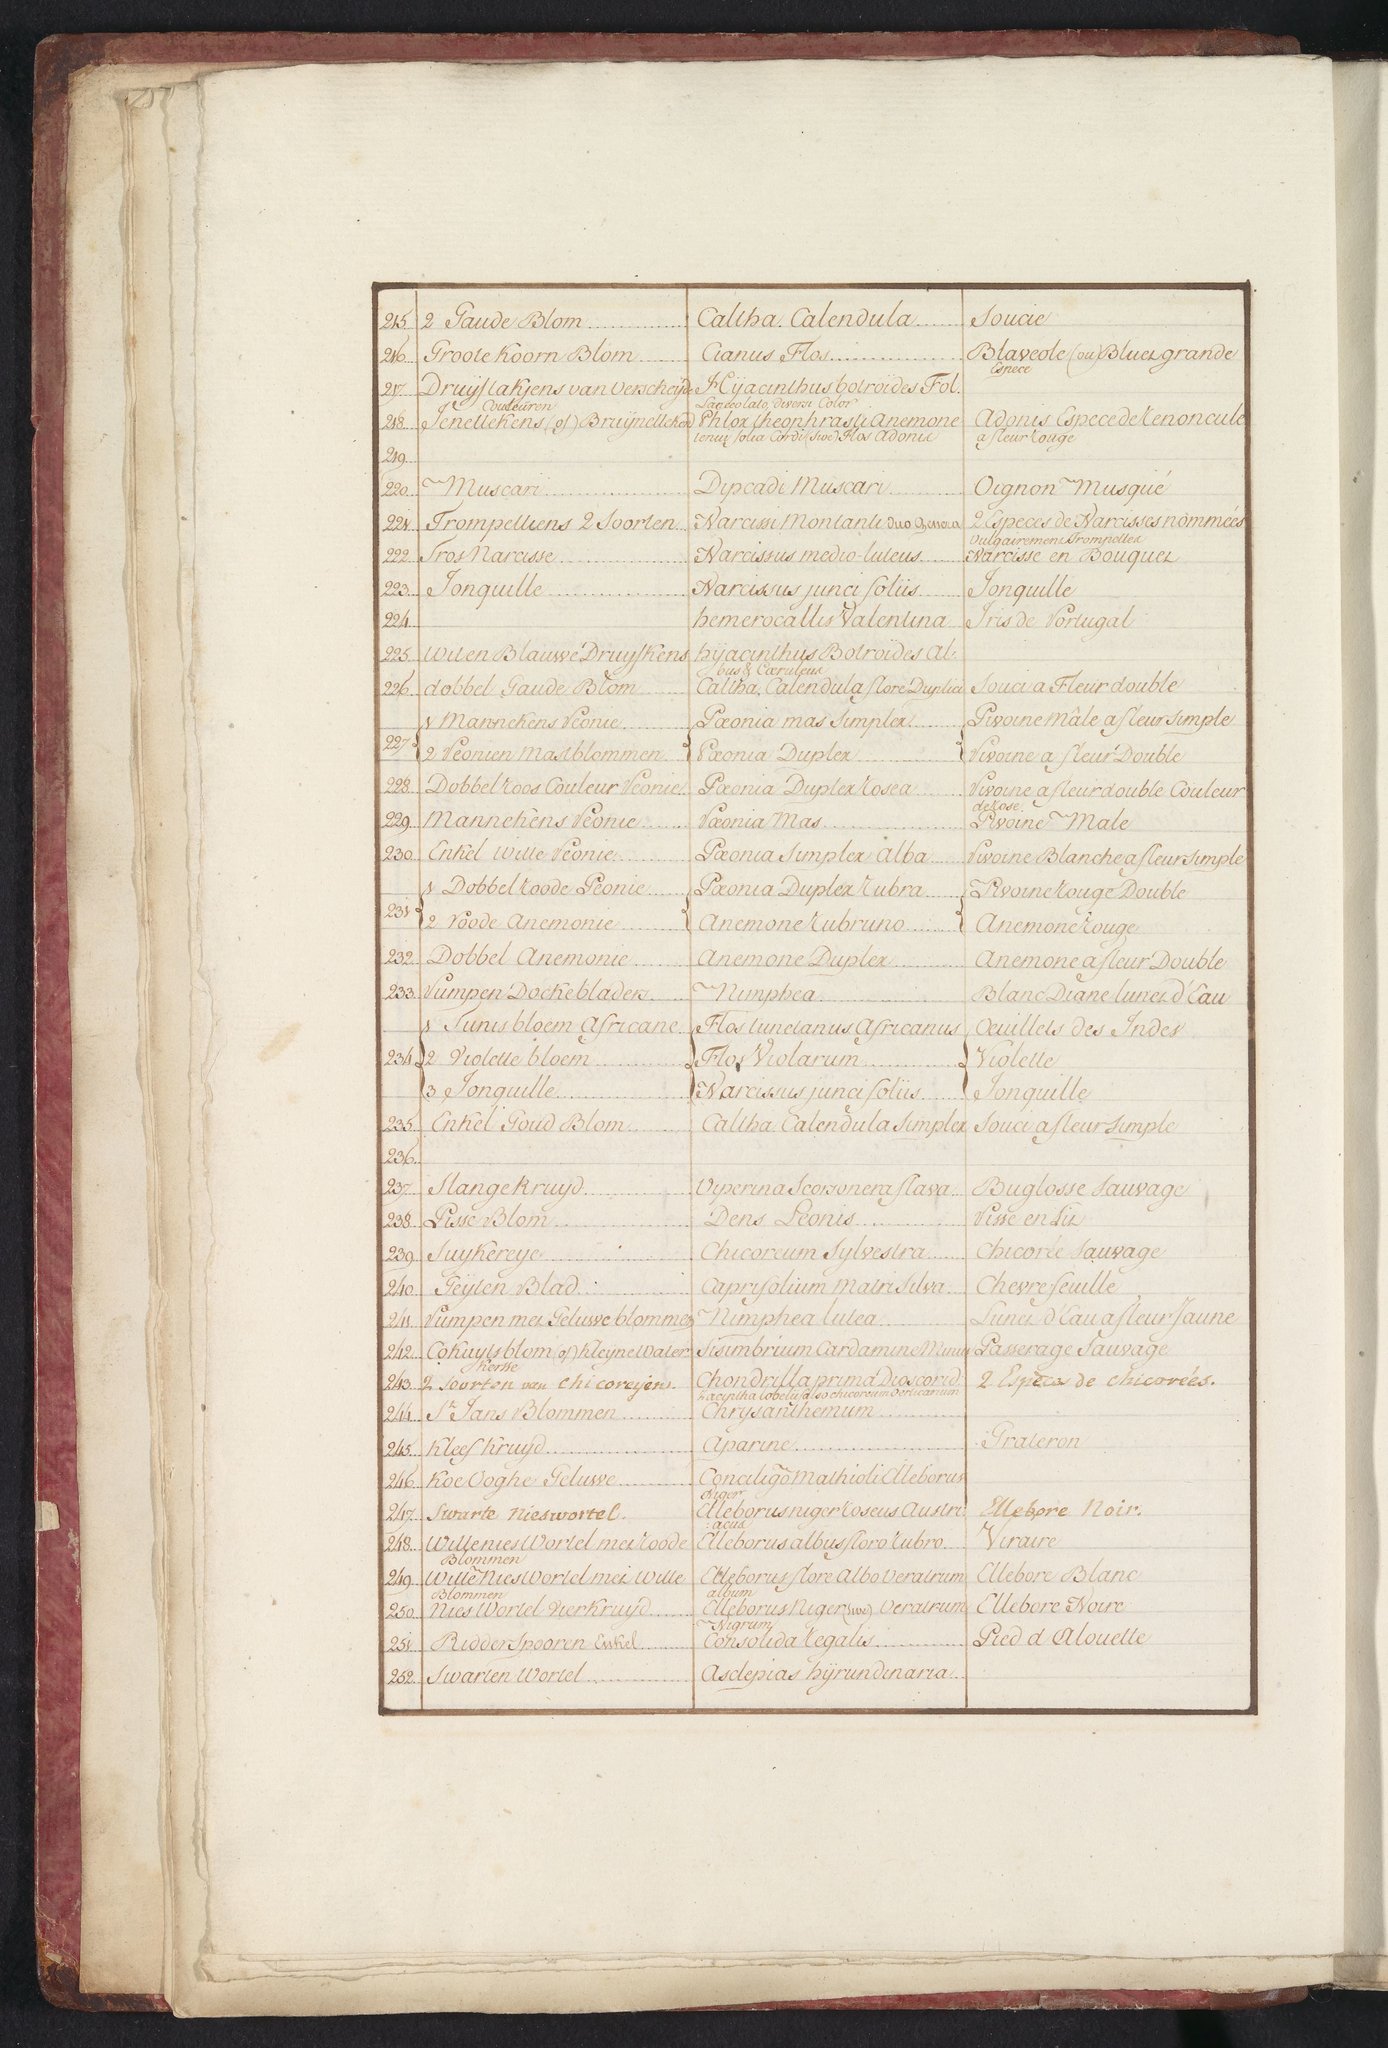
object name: manuscript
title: Lijst van alle bloemen in de vier albums over bloemen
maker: joseph van huerne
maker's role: kunstliefhebber, mecenas, verzamelaar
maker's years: 1752-1844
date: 1809-1814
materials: ink, paper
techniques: handwriting, pen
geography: bruges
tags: handwriting, written text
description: Schema met een lijst van de namen in het Vlaams, Latijn en Frans van de bloemen voorgesteld in de vier delen van de planten: nummers 215-262. Onderdeel van het eerste album met tekeningen van bloemen. Achtste van twaalf albums met tekeningen van dieren, vogels en planten bekend rond 1600, gemaakt in opdracht van keizer Rudolf II. Met toelichting in Nederlands, Latijn en Frans.